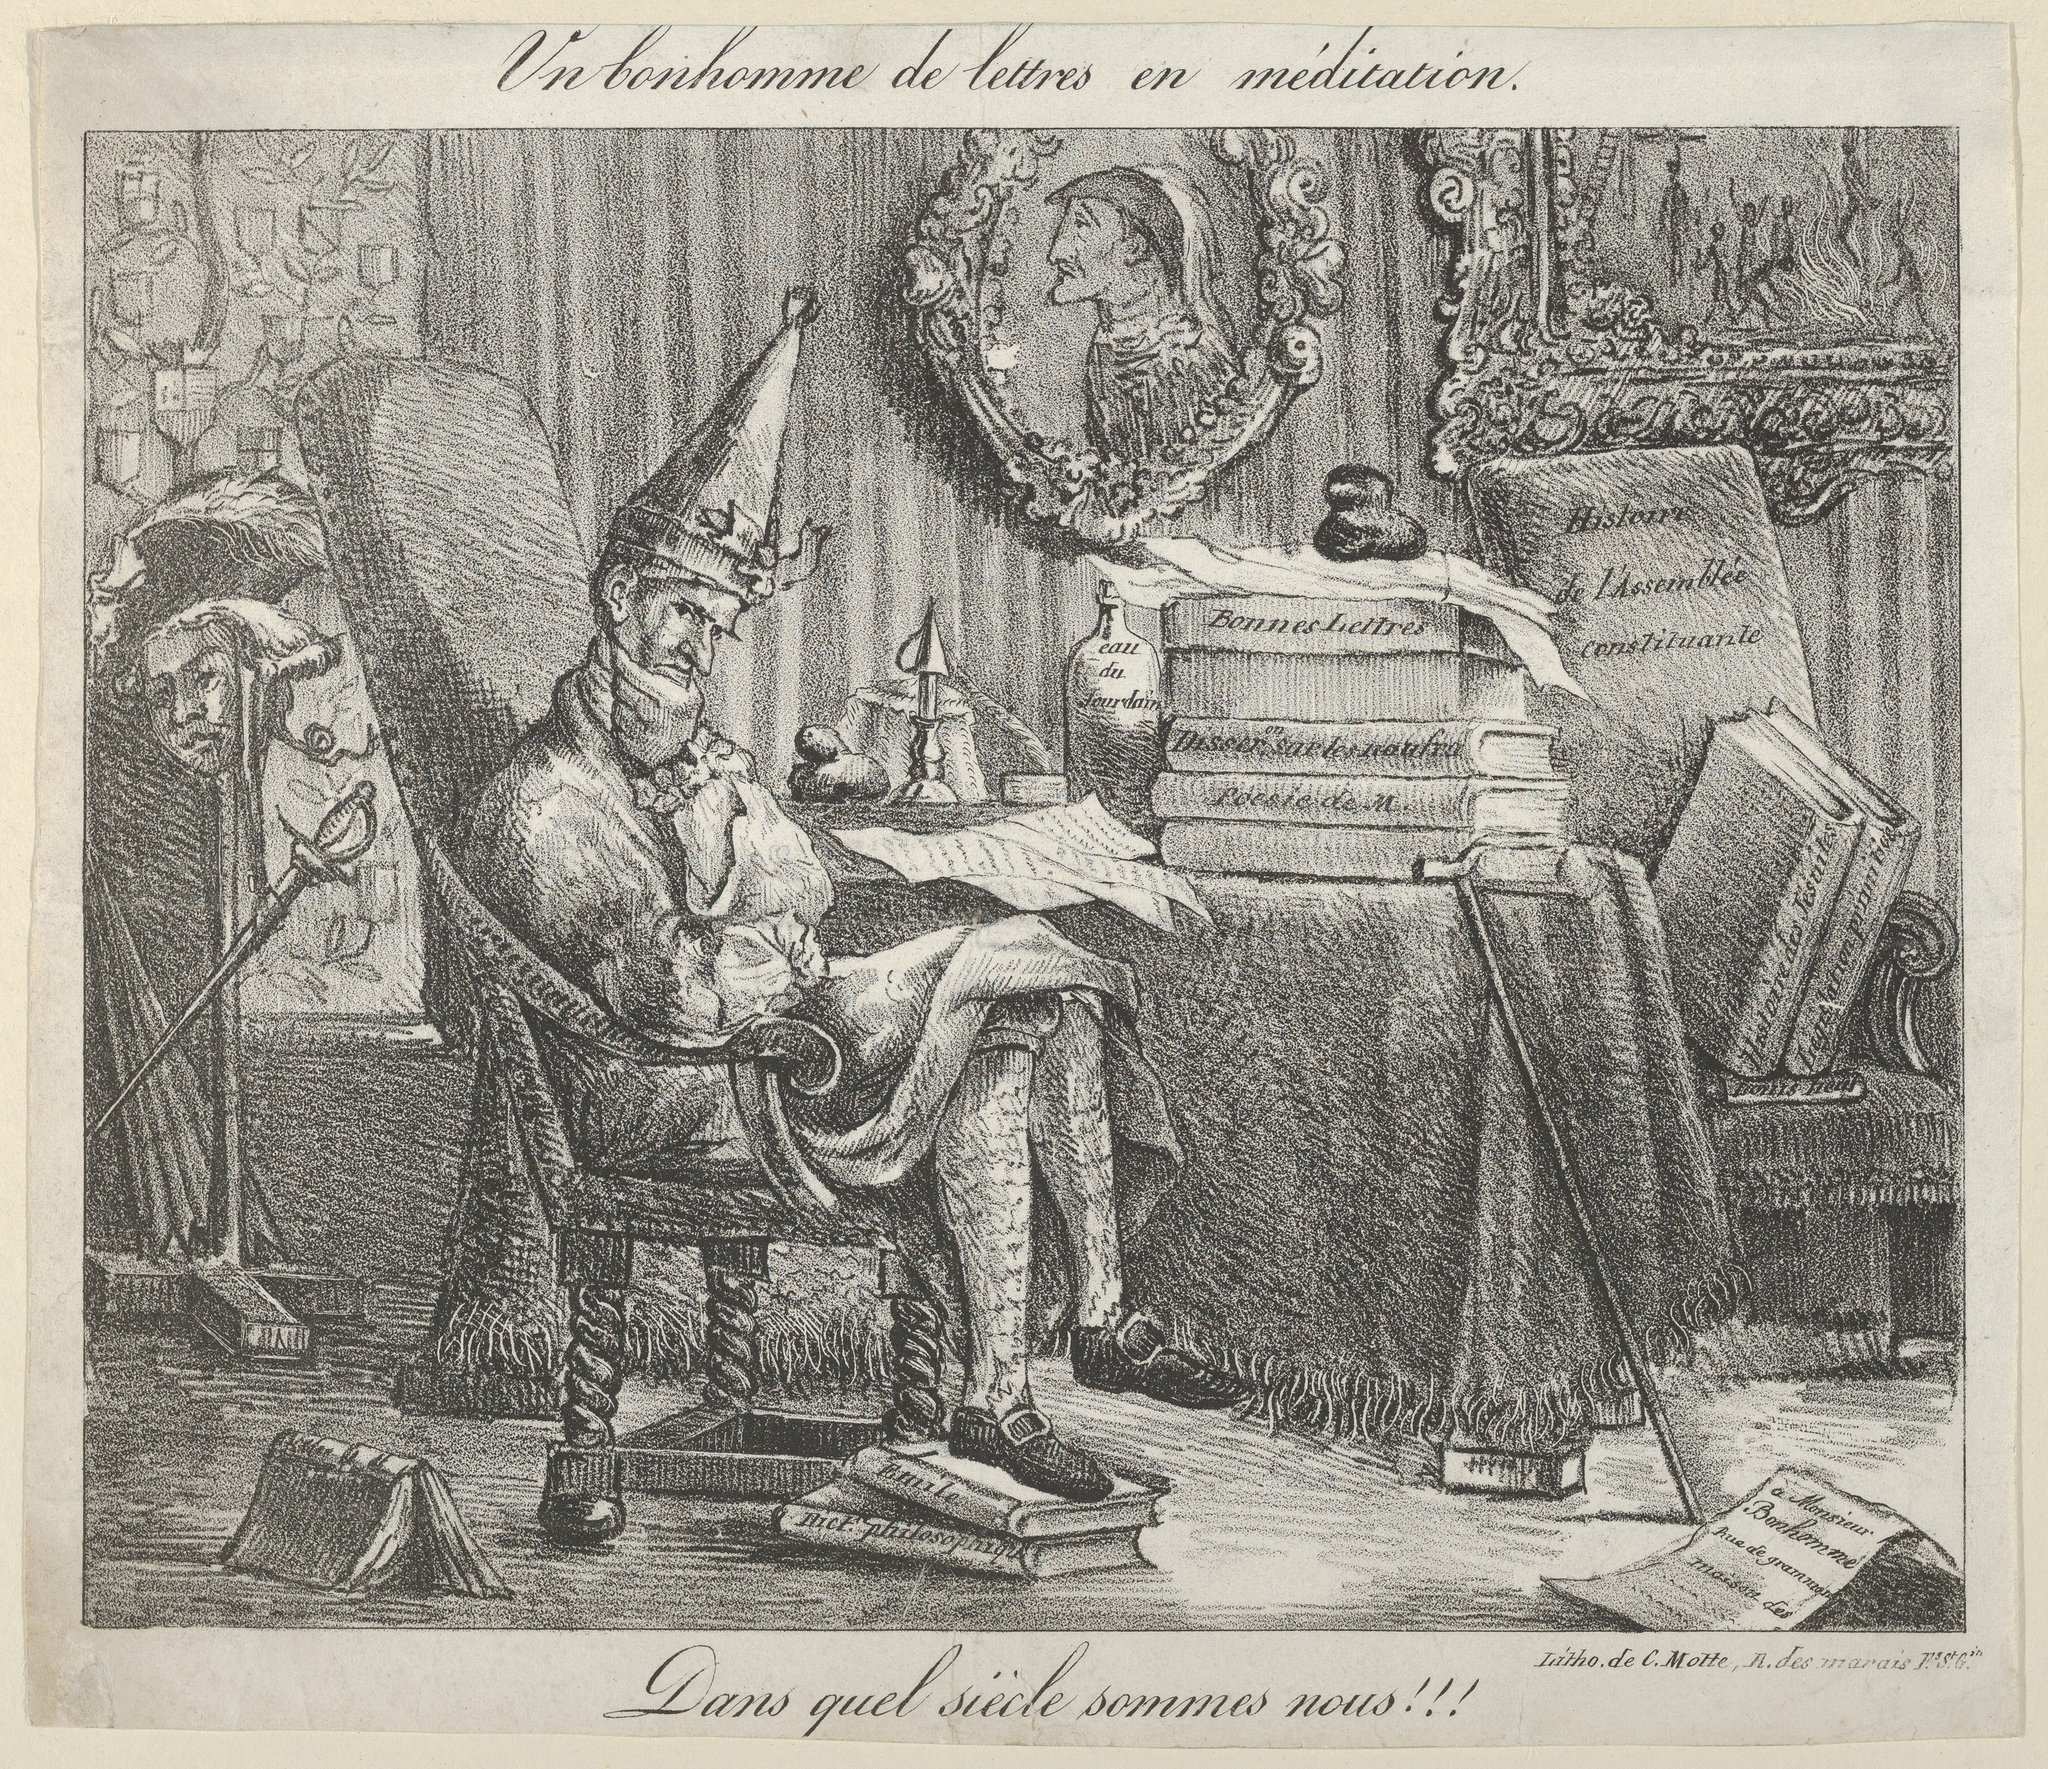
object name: print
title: A Literary Fellow Meditating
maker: eugène delacroix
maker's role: artist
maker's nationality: french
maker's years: 1798-1863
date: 1821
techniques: lithograph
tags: books,men